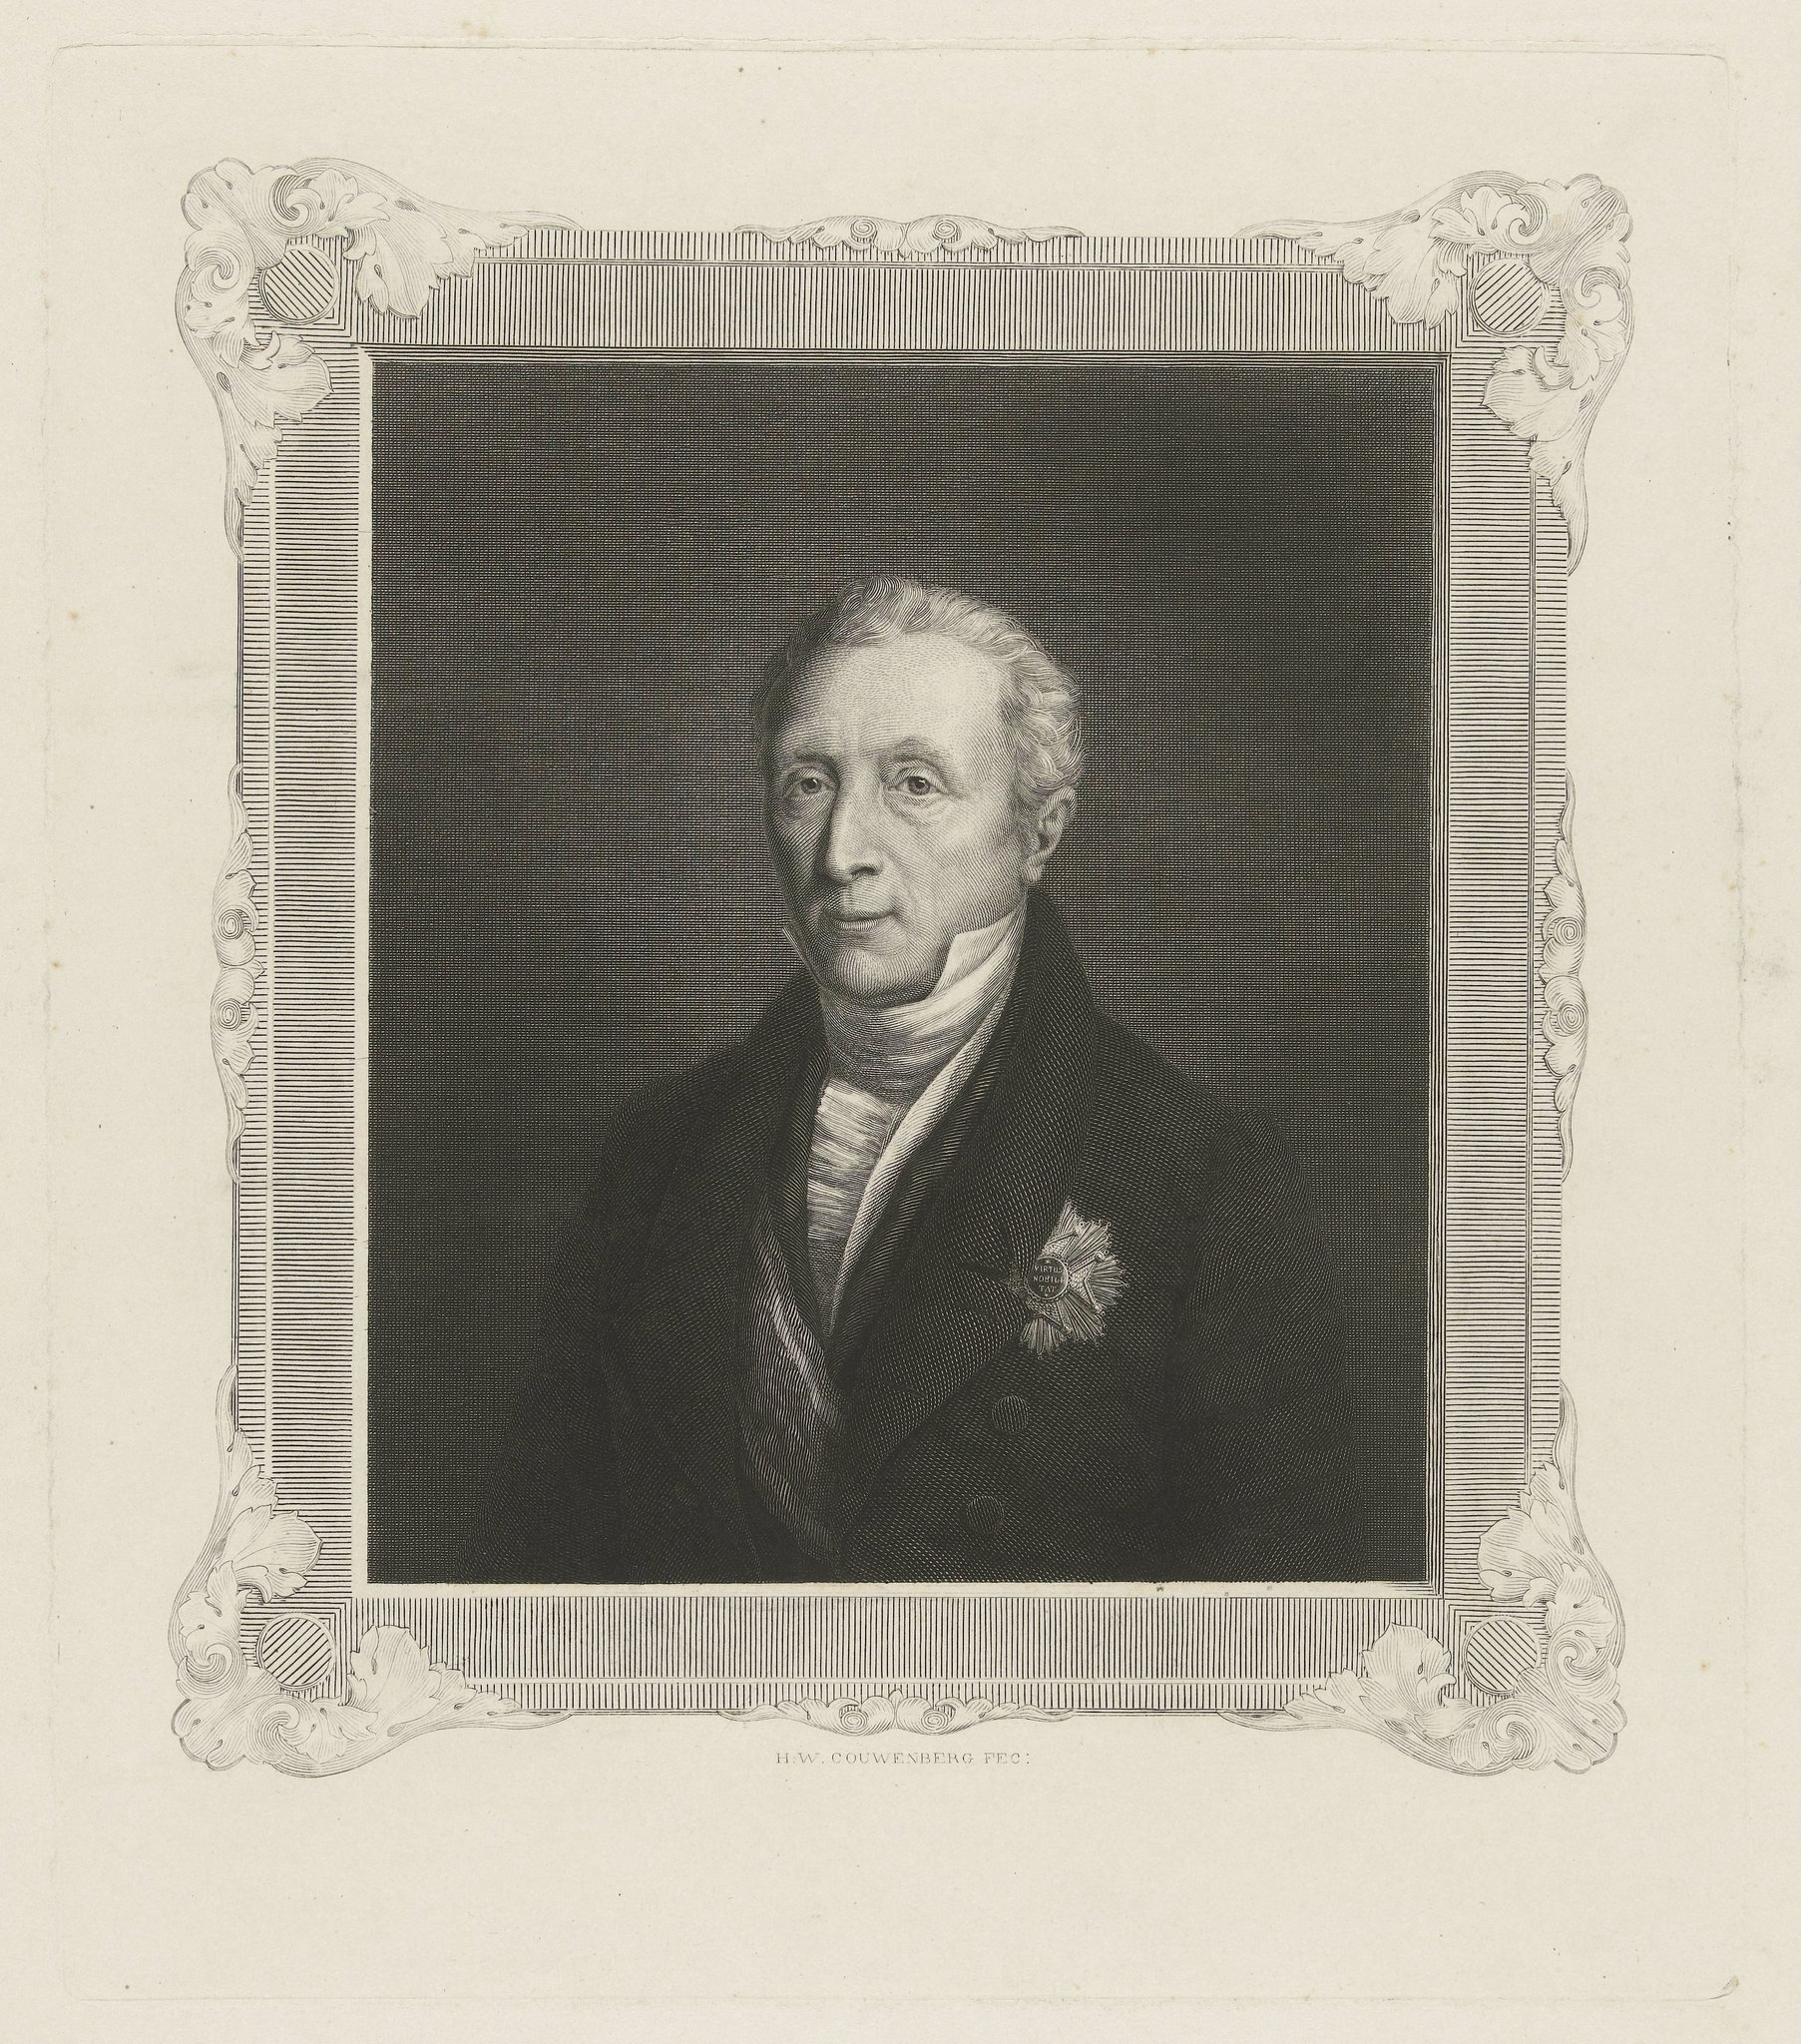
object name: print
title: Portret van Willem Frederik baron van Roëll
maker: henricus wilhelmus couwenberg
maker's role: draughtsman, print maker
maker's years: 1814-1845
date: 1835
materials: paper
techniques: engraving, etching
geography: amsterdam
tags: willem frederik baron roëll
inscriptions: collector's mark: Lugt 2228